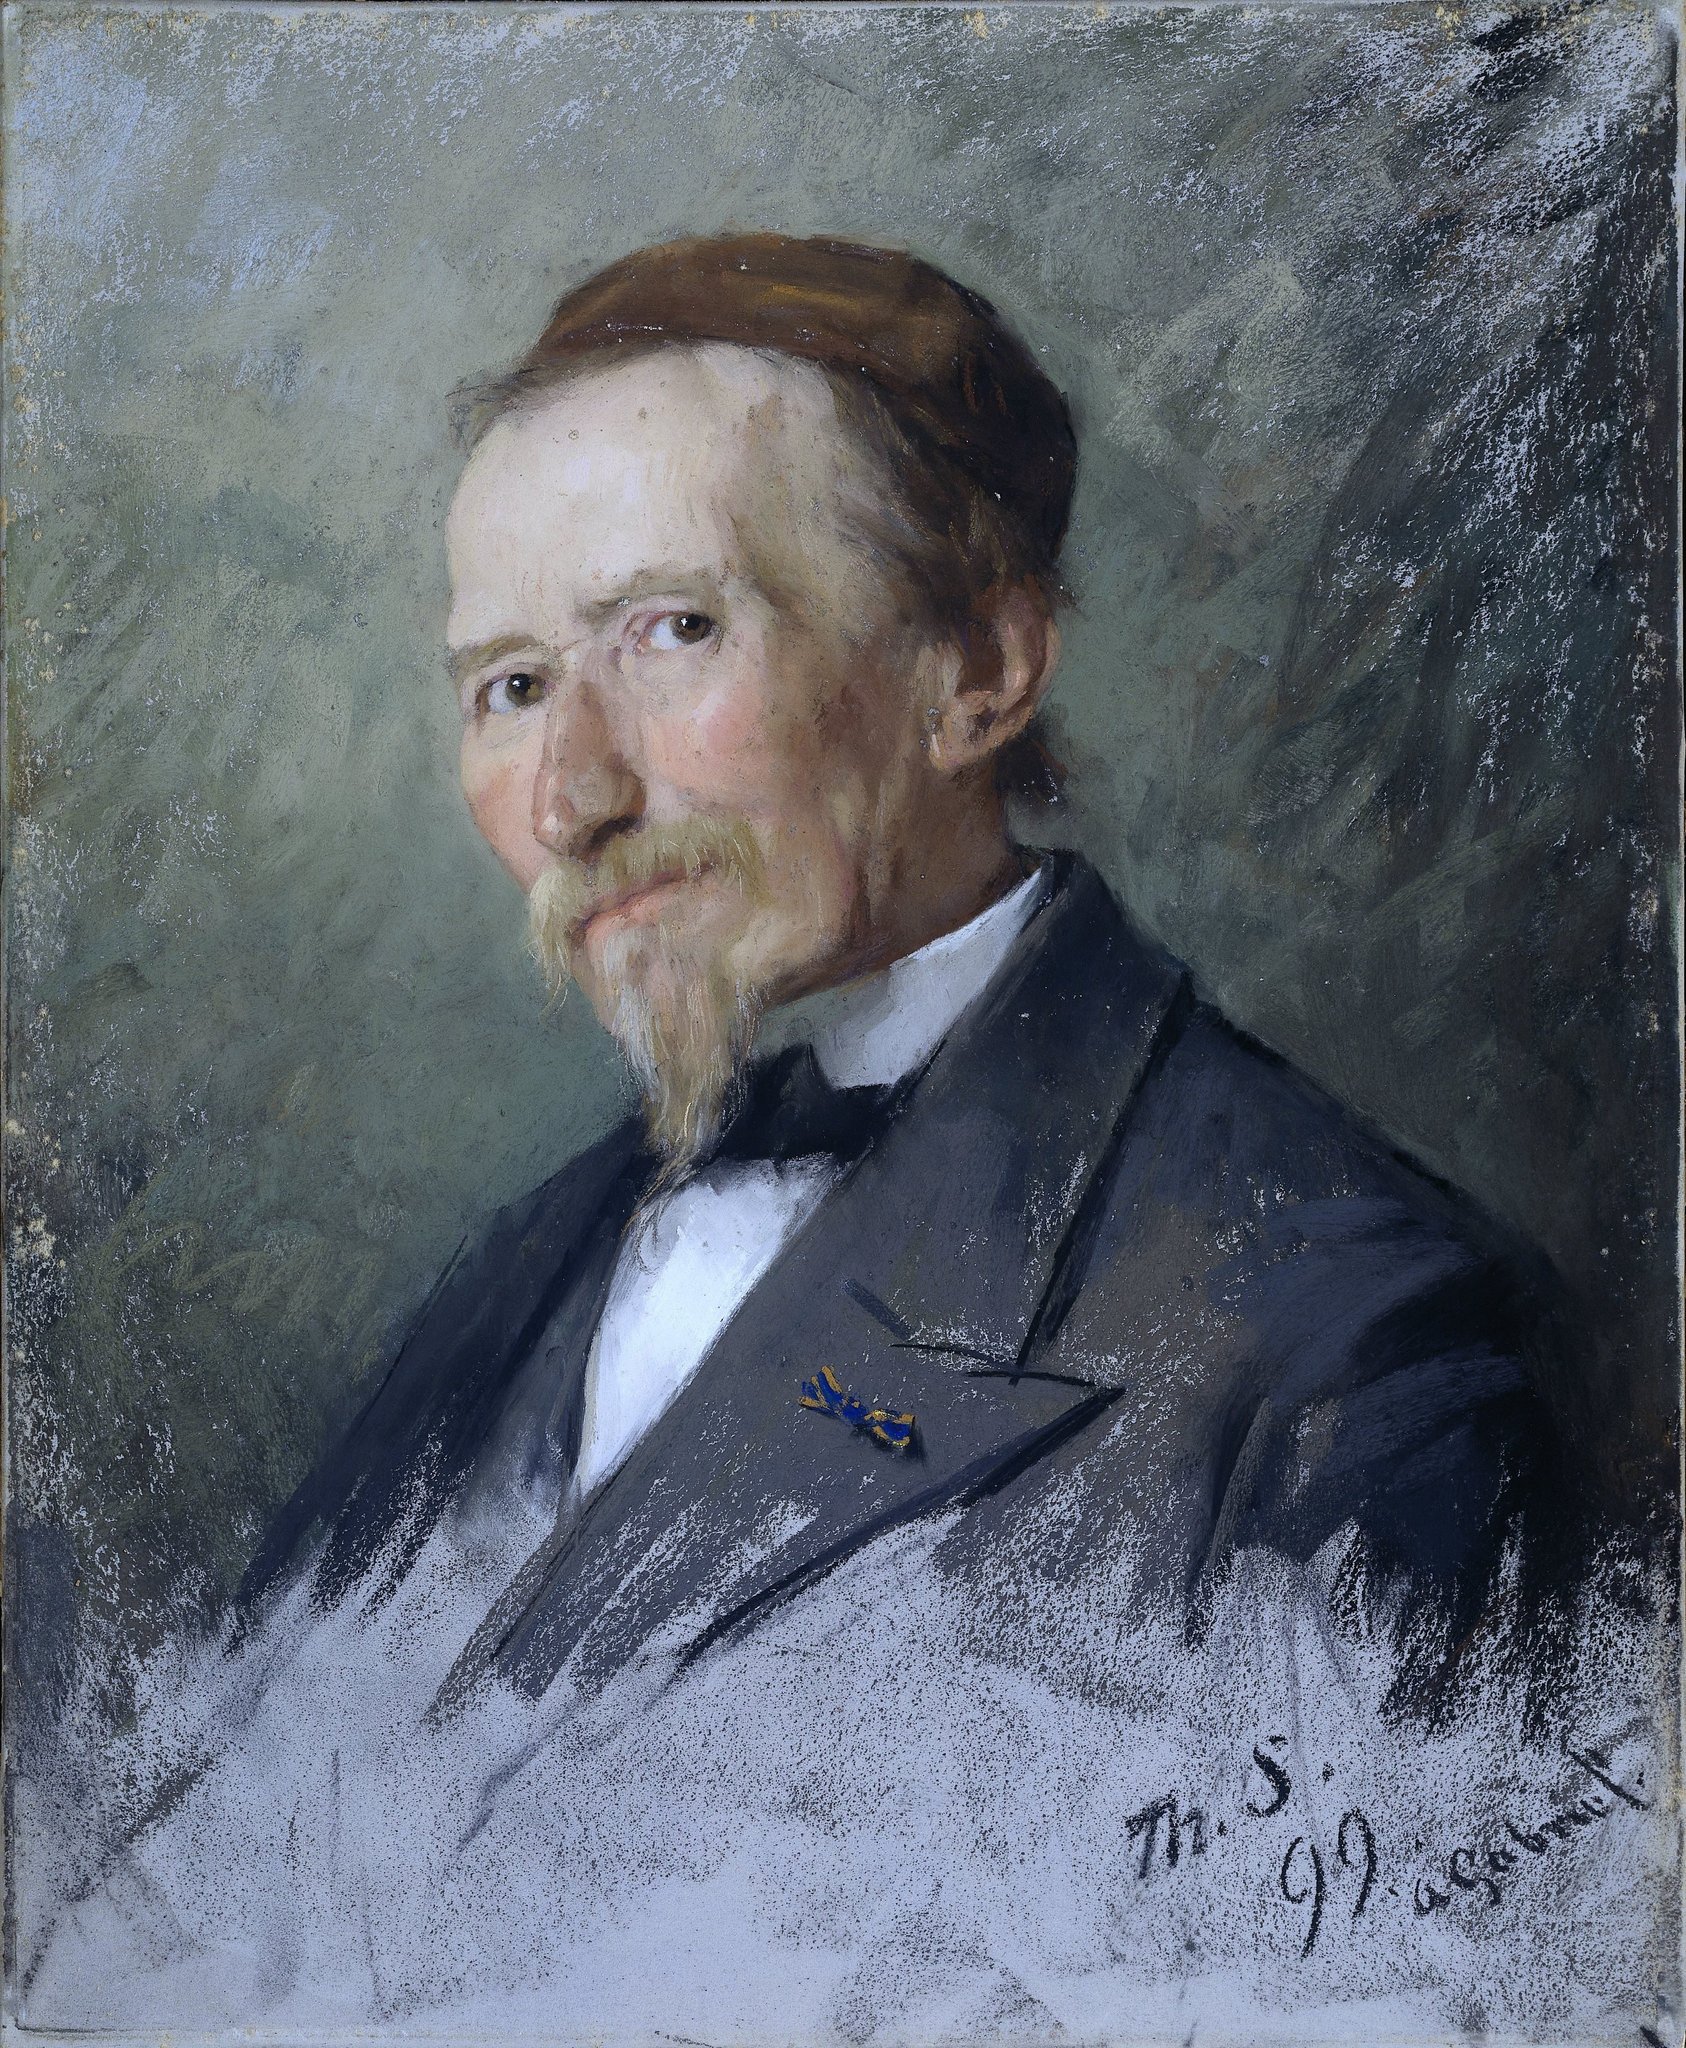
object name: drawing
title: Paul Joseph Constantin Gabriël (1828-1903). Schilder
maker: thérèse schwartze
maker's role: draughtsman, painter, print maker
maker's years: 1851-1918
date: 1899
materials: paper, pastel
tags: amsterdam, print maker, draughtsman, paul joseph constantin gabriël, portrait, self-portrait of artist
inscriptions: signature and date: ‘Th. S. 99. à Gabriel’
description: Portret van de schilder Paul Joseph Constantin Gabriël (1828-1903). Buste naar links, de beschouwer aanziend.